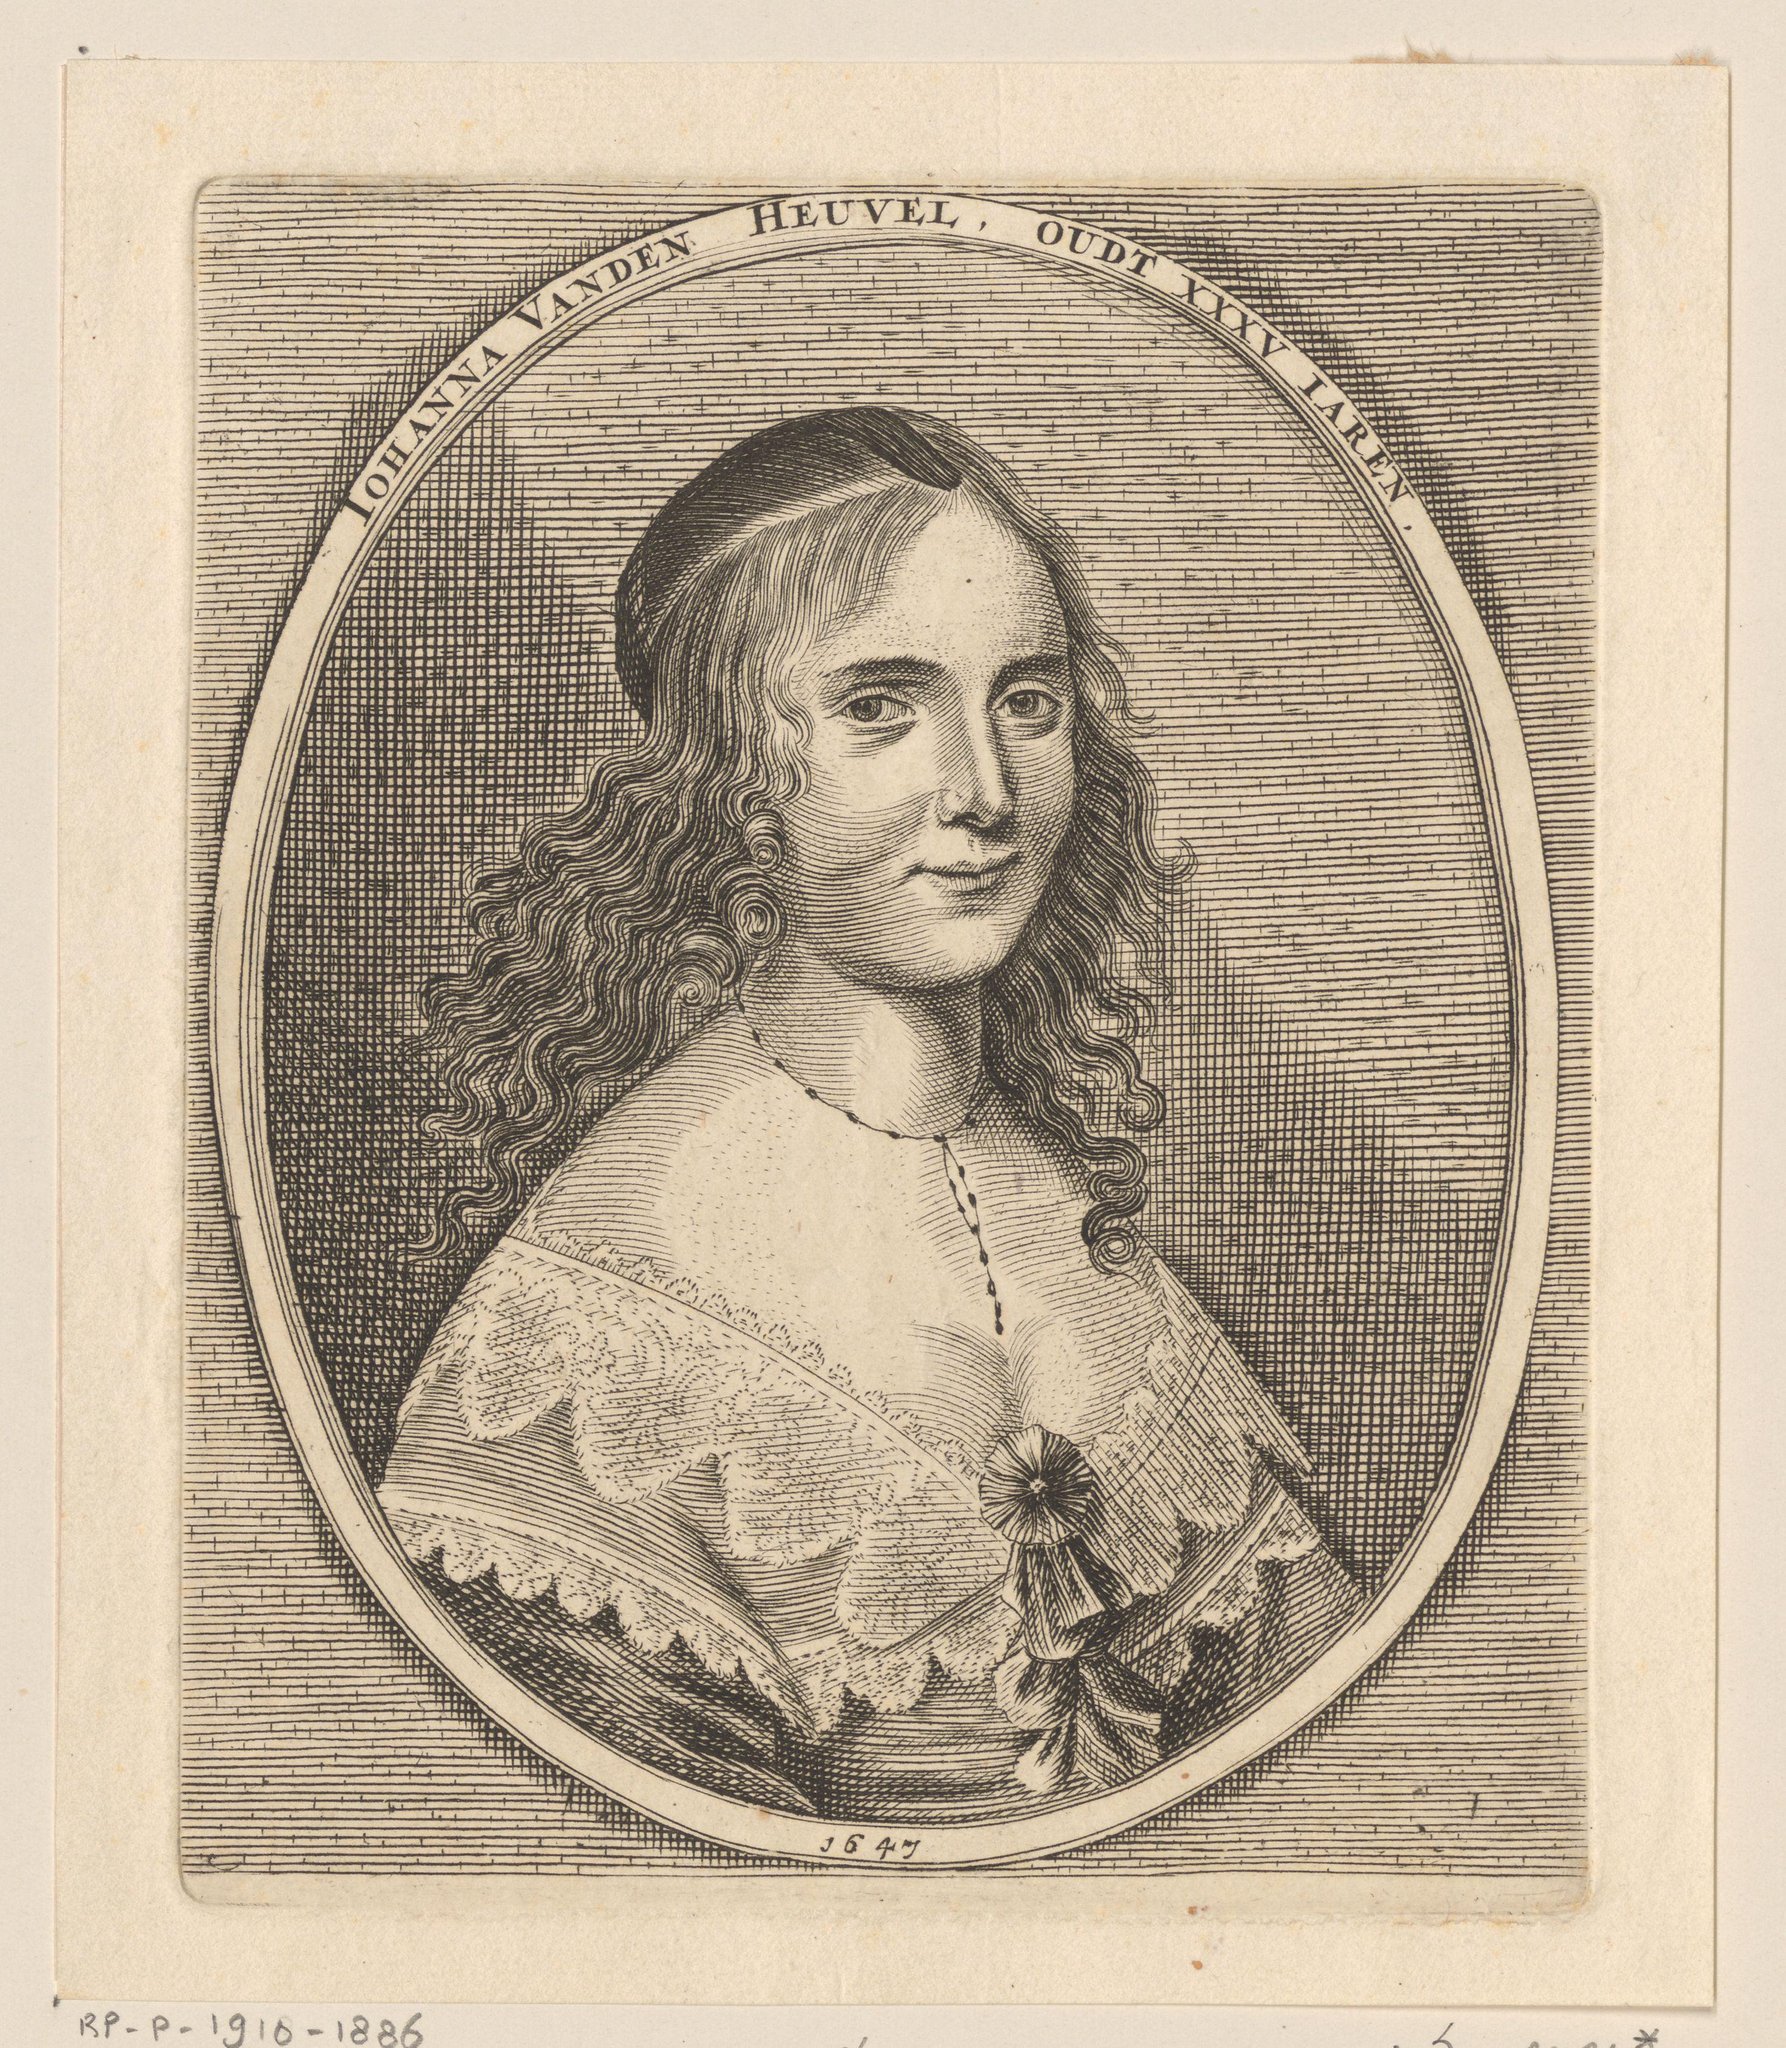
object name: print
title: Portret van Johanna van den Heuvel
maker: Anonymous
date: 1647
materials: paper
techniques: engraving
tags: historical persons - bb - woman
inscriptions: collector's mark: Lugt 2228